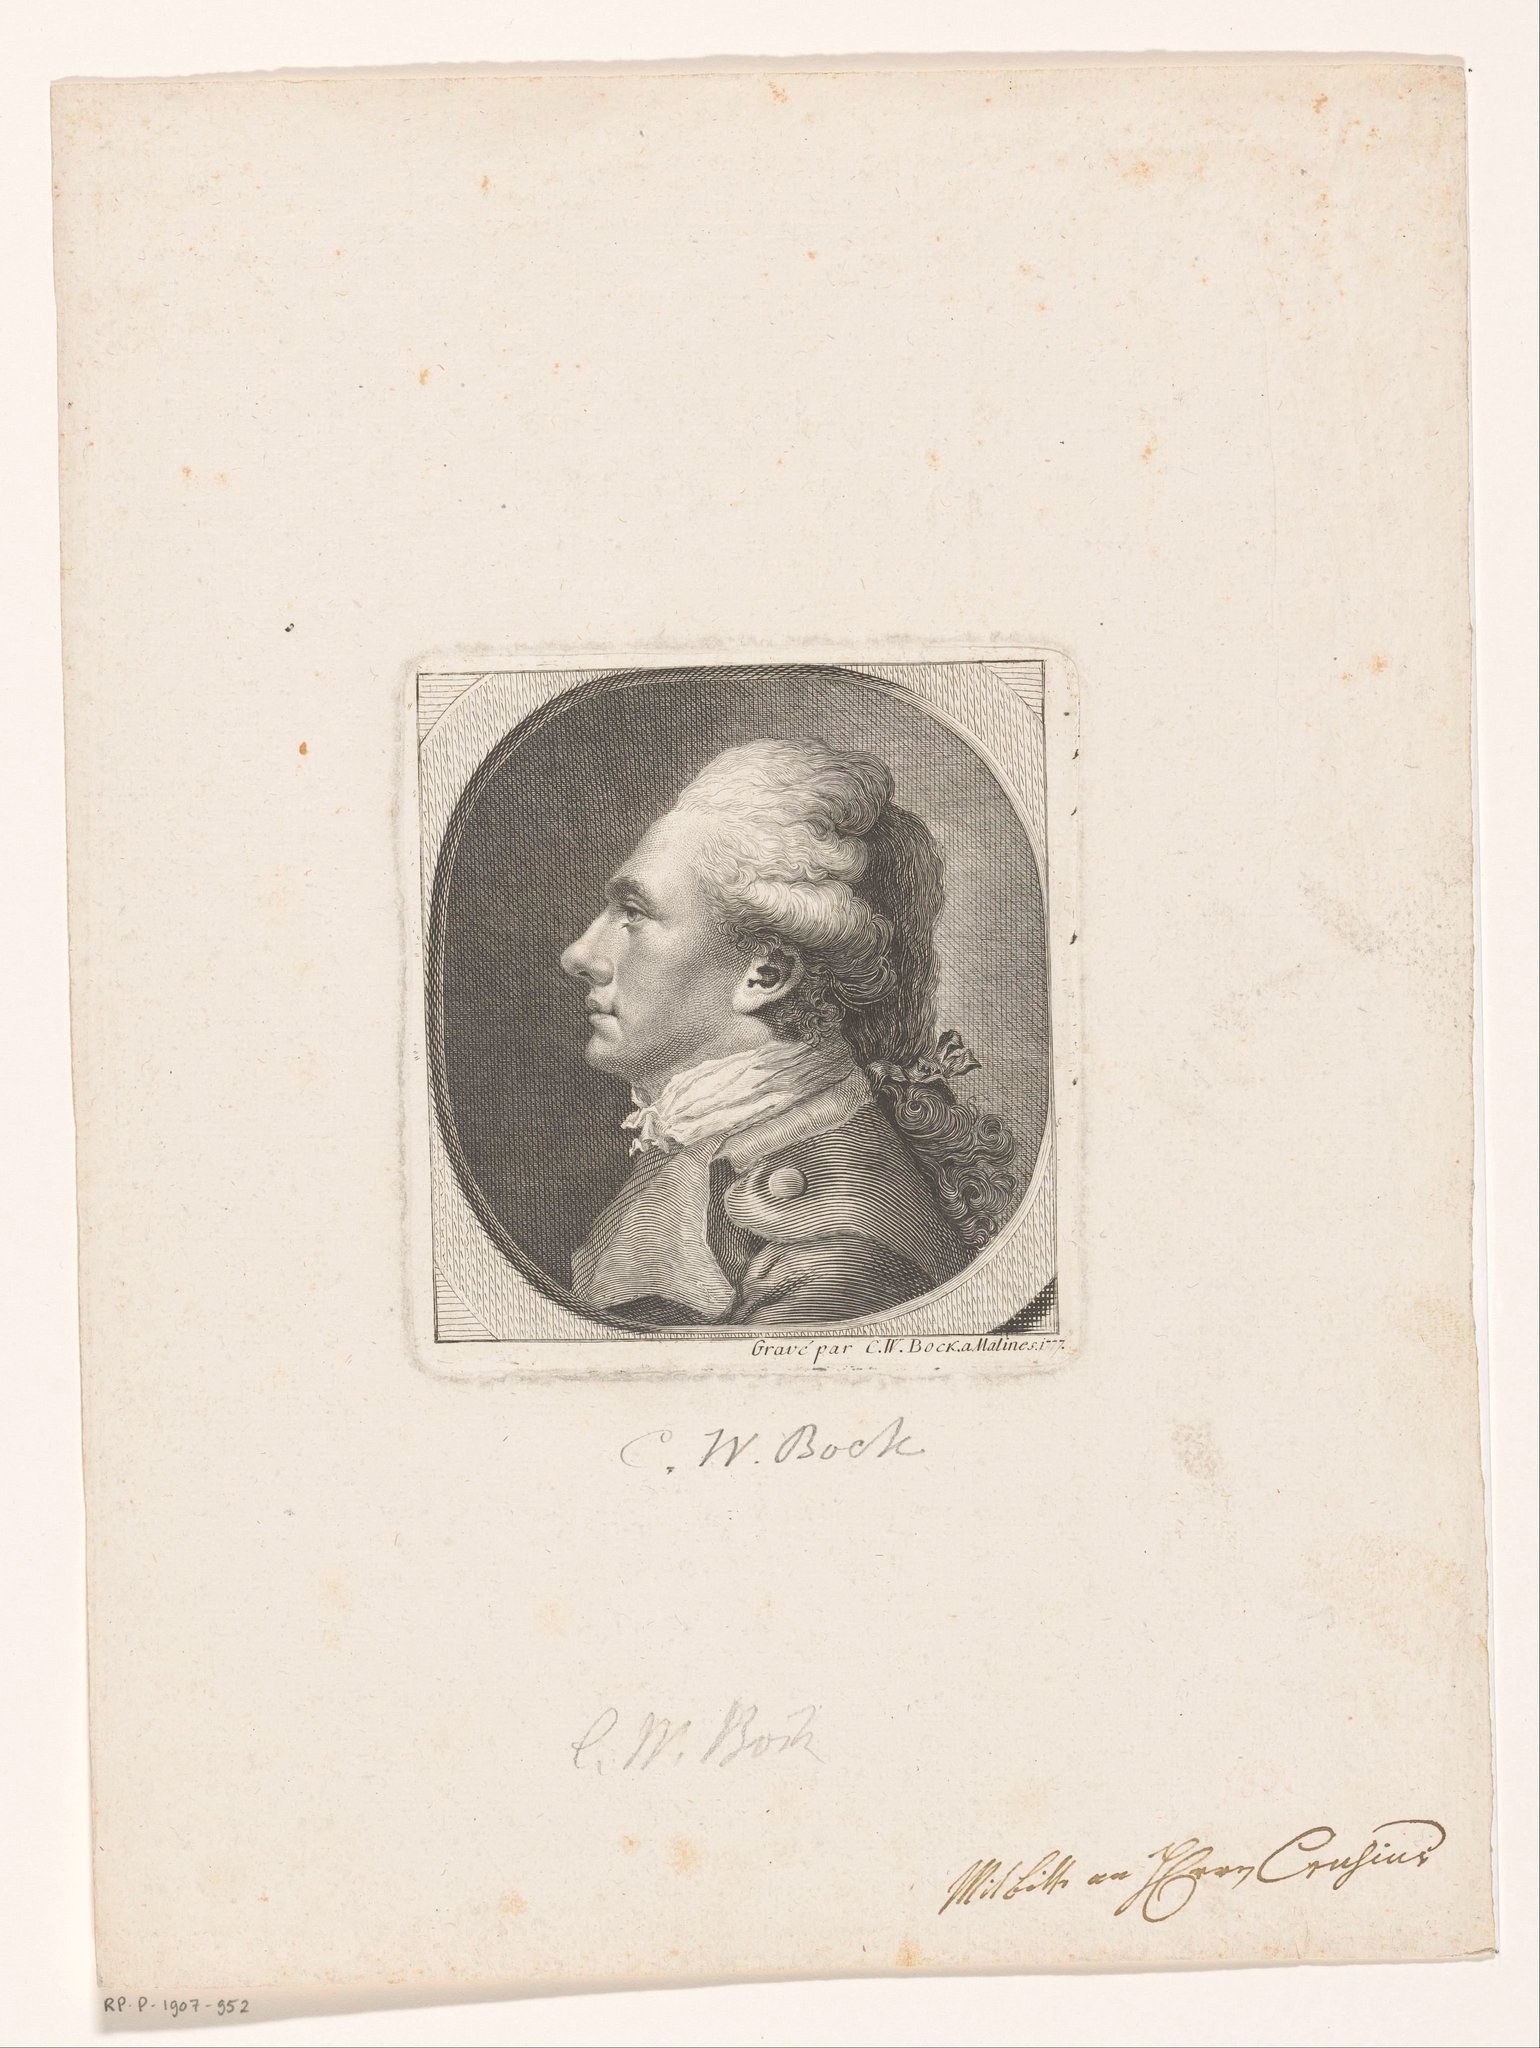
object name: print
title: Zelfportret van Christoph Wilhelm Bock op 22-jarige leeftijd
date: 1777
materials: paper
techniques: engraving, etching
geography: mechelen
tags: print maker, christoph wilhelm bock, portrait, self-portrait of graphic artist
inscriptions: inscription: ‘Mit bitte an Herrn (?) Crusius’, collector's mark: Lugt 2228